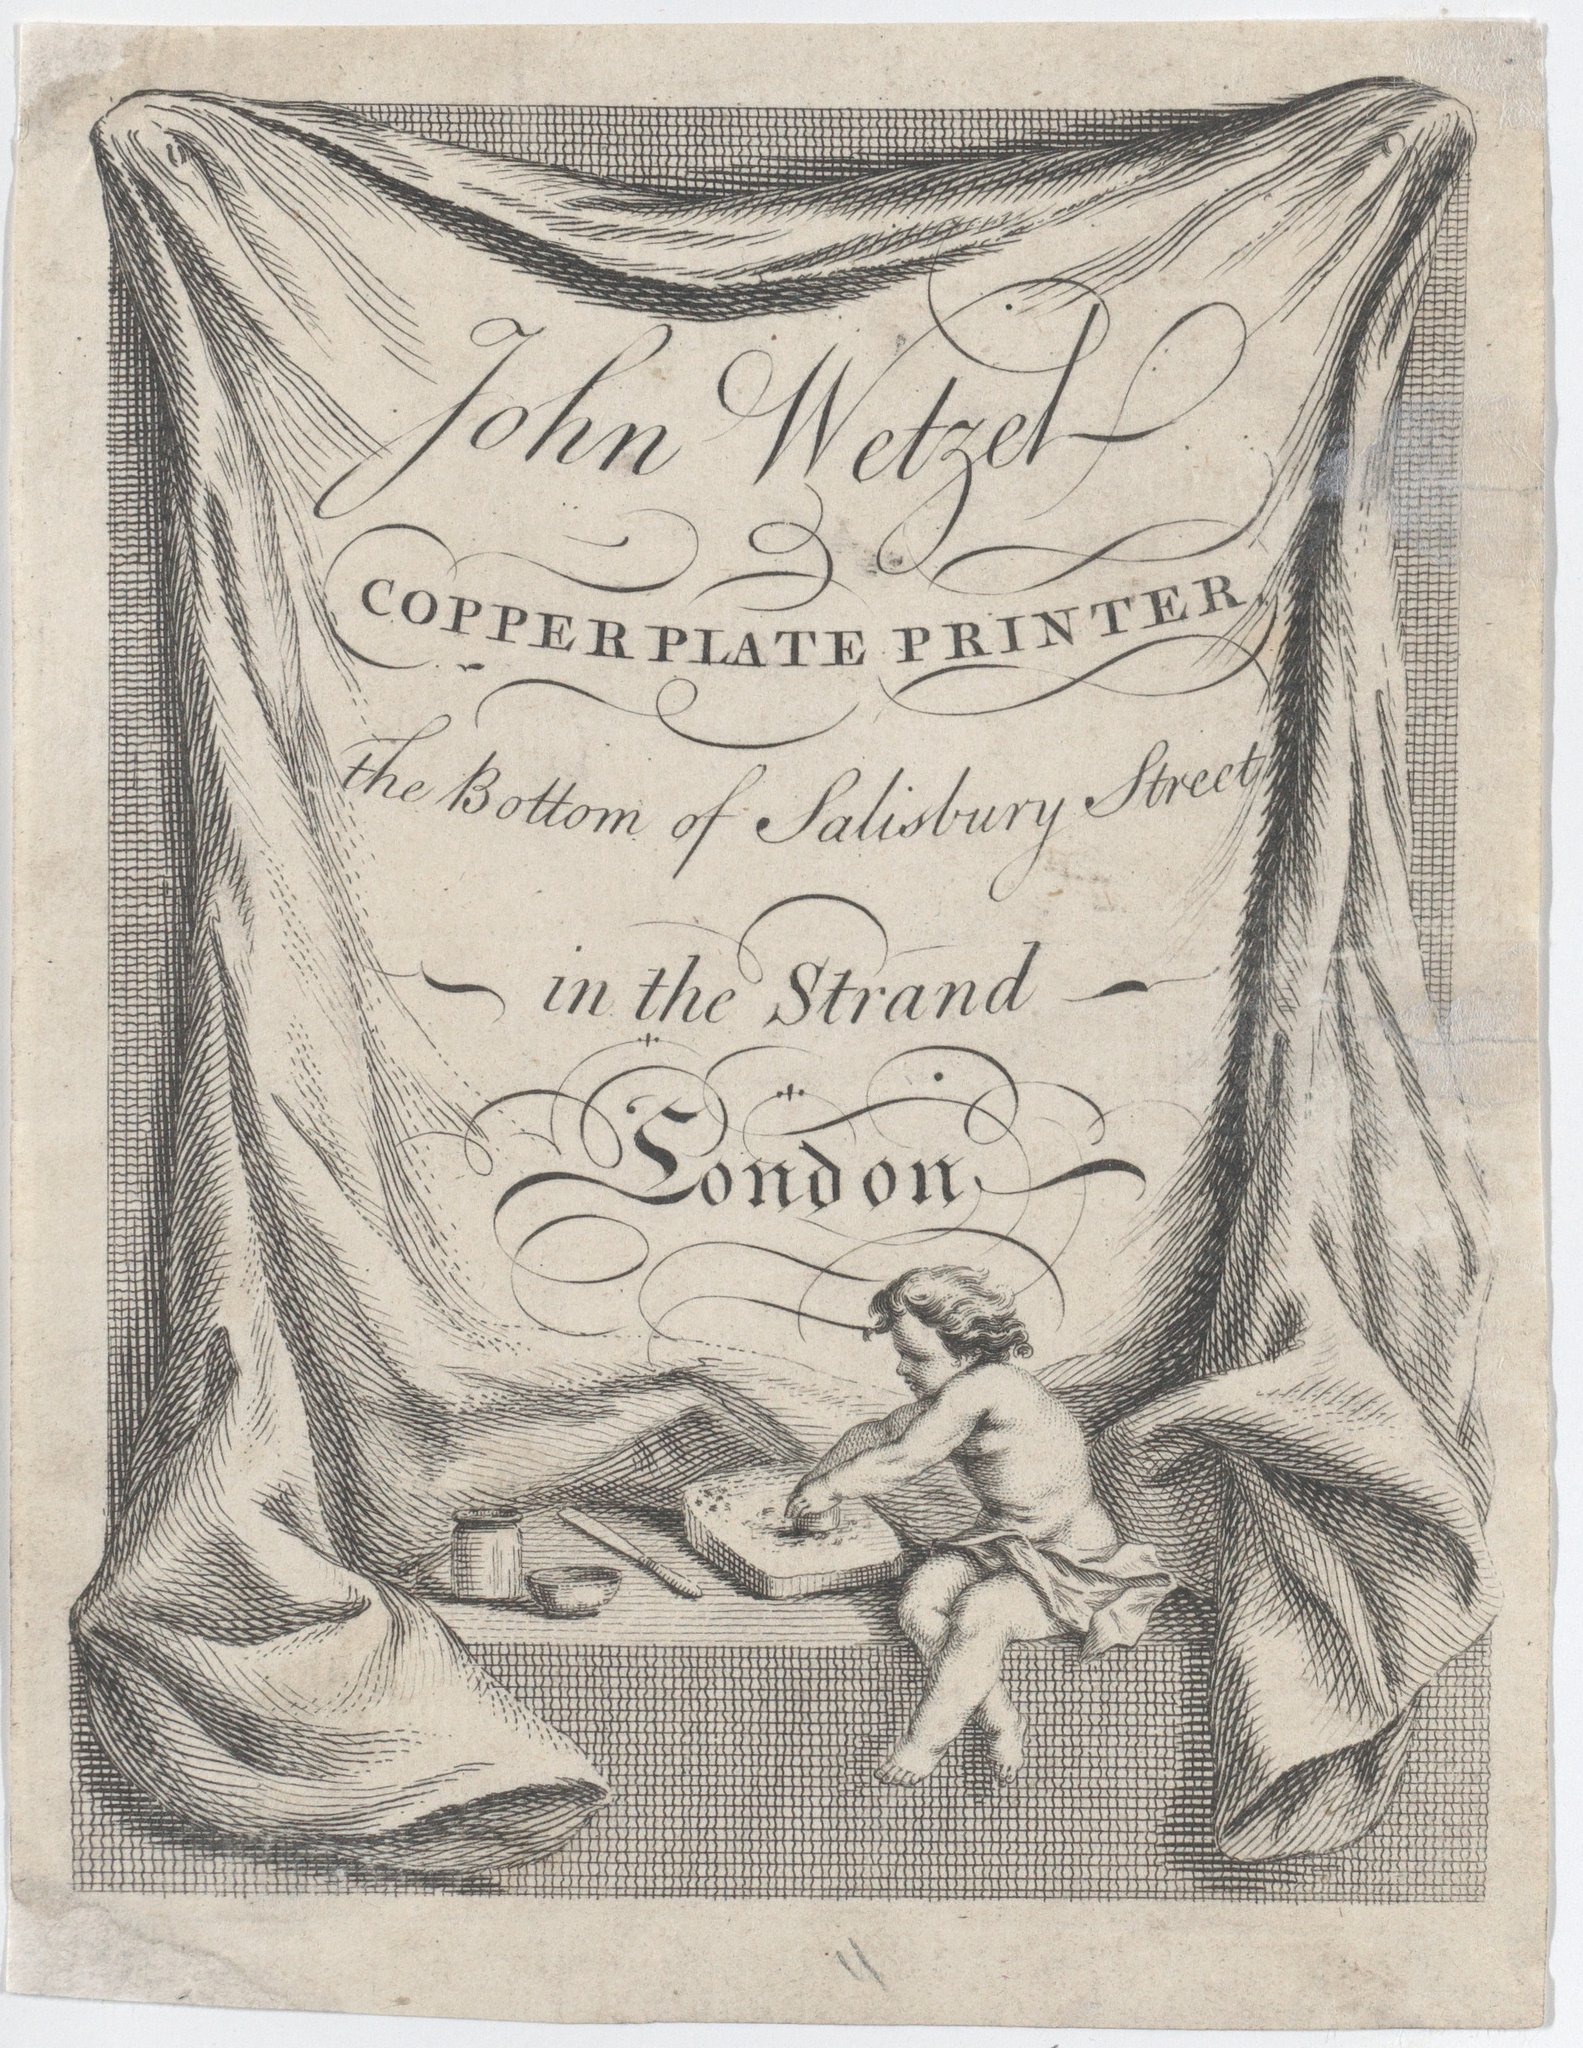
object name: print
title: Trade card for John Wetzel, Copperplate Printer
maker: Anonymous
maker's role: artist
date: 1701-1800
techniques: etching